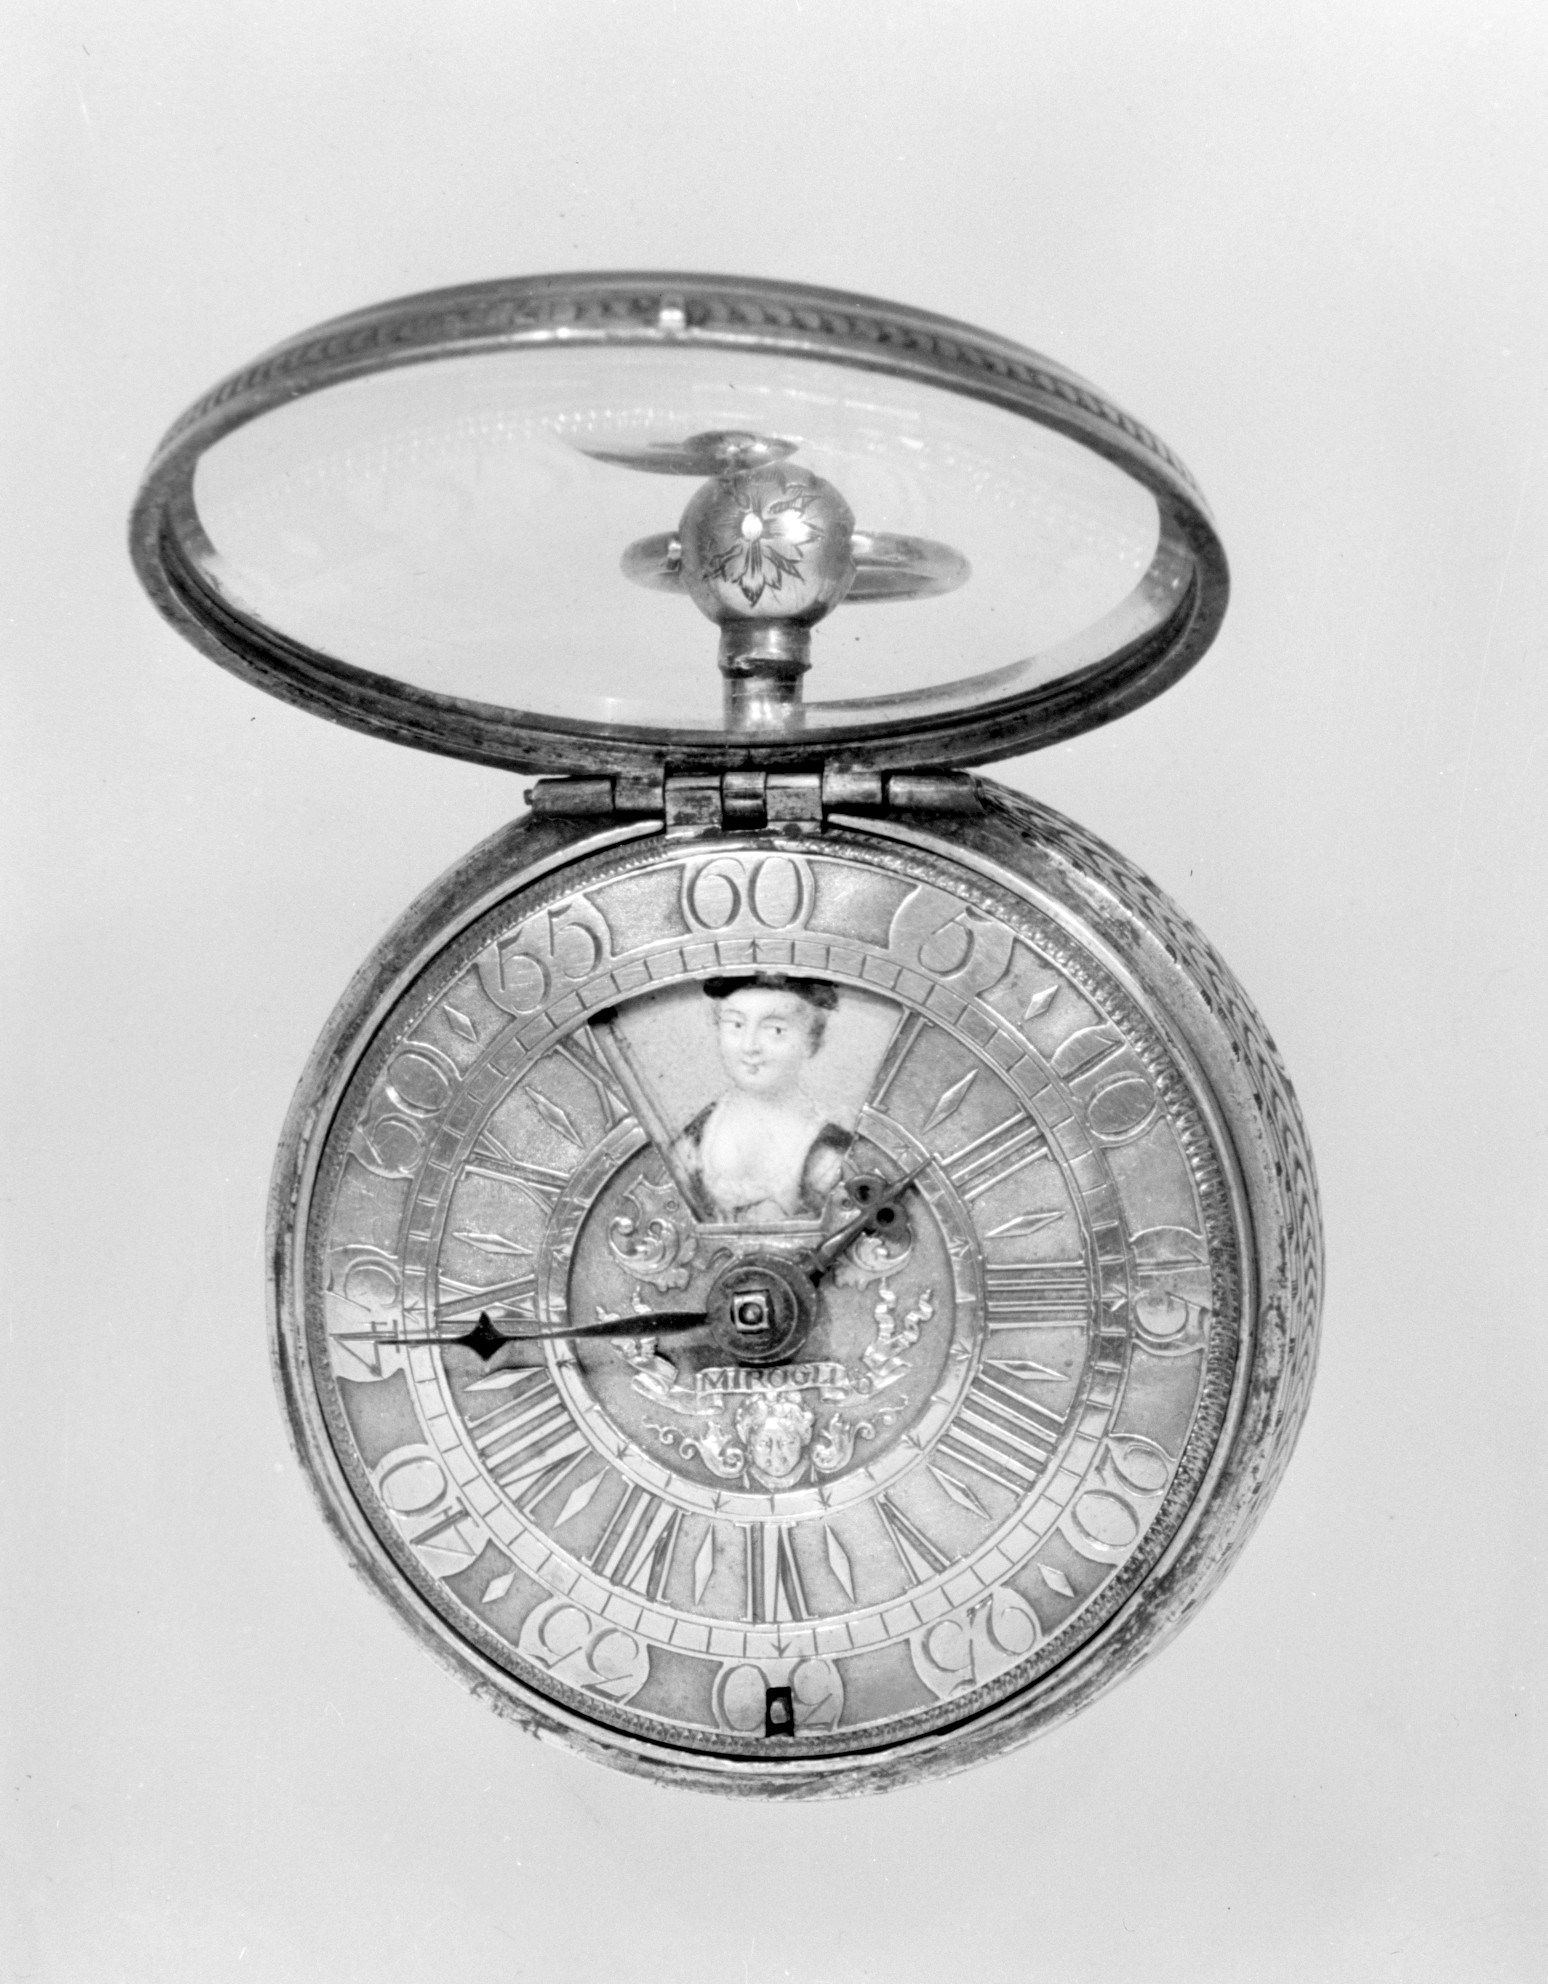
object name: watch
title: Watch with revolving portraits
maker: denis miroglio (or miroli)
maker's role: maker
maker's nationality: swiss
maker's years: 1682-1748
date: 1701-1800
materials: enamel, niello, silver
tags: women,coat of arms